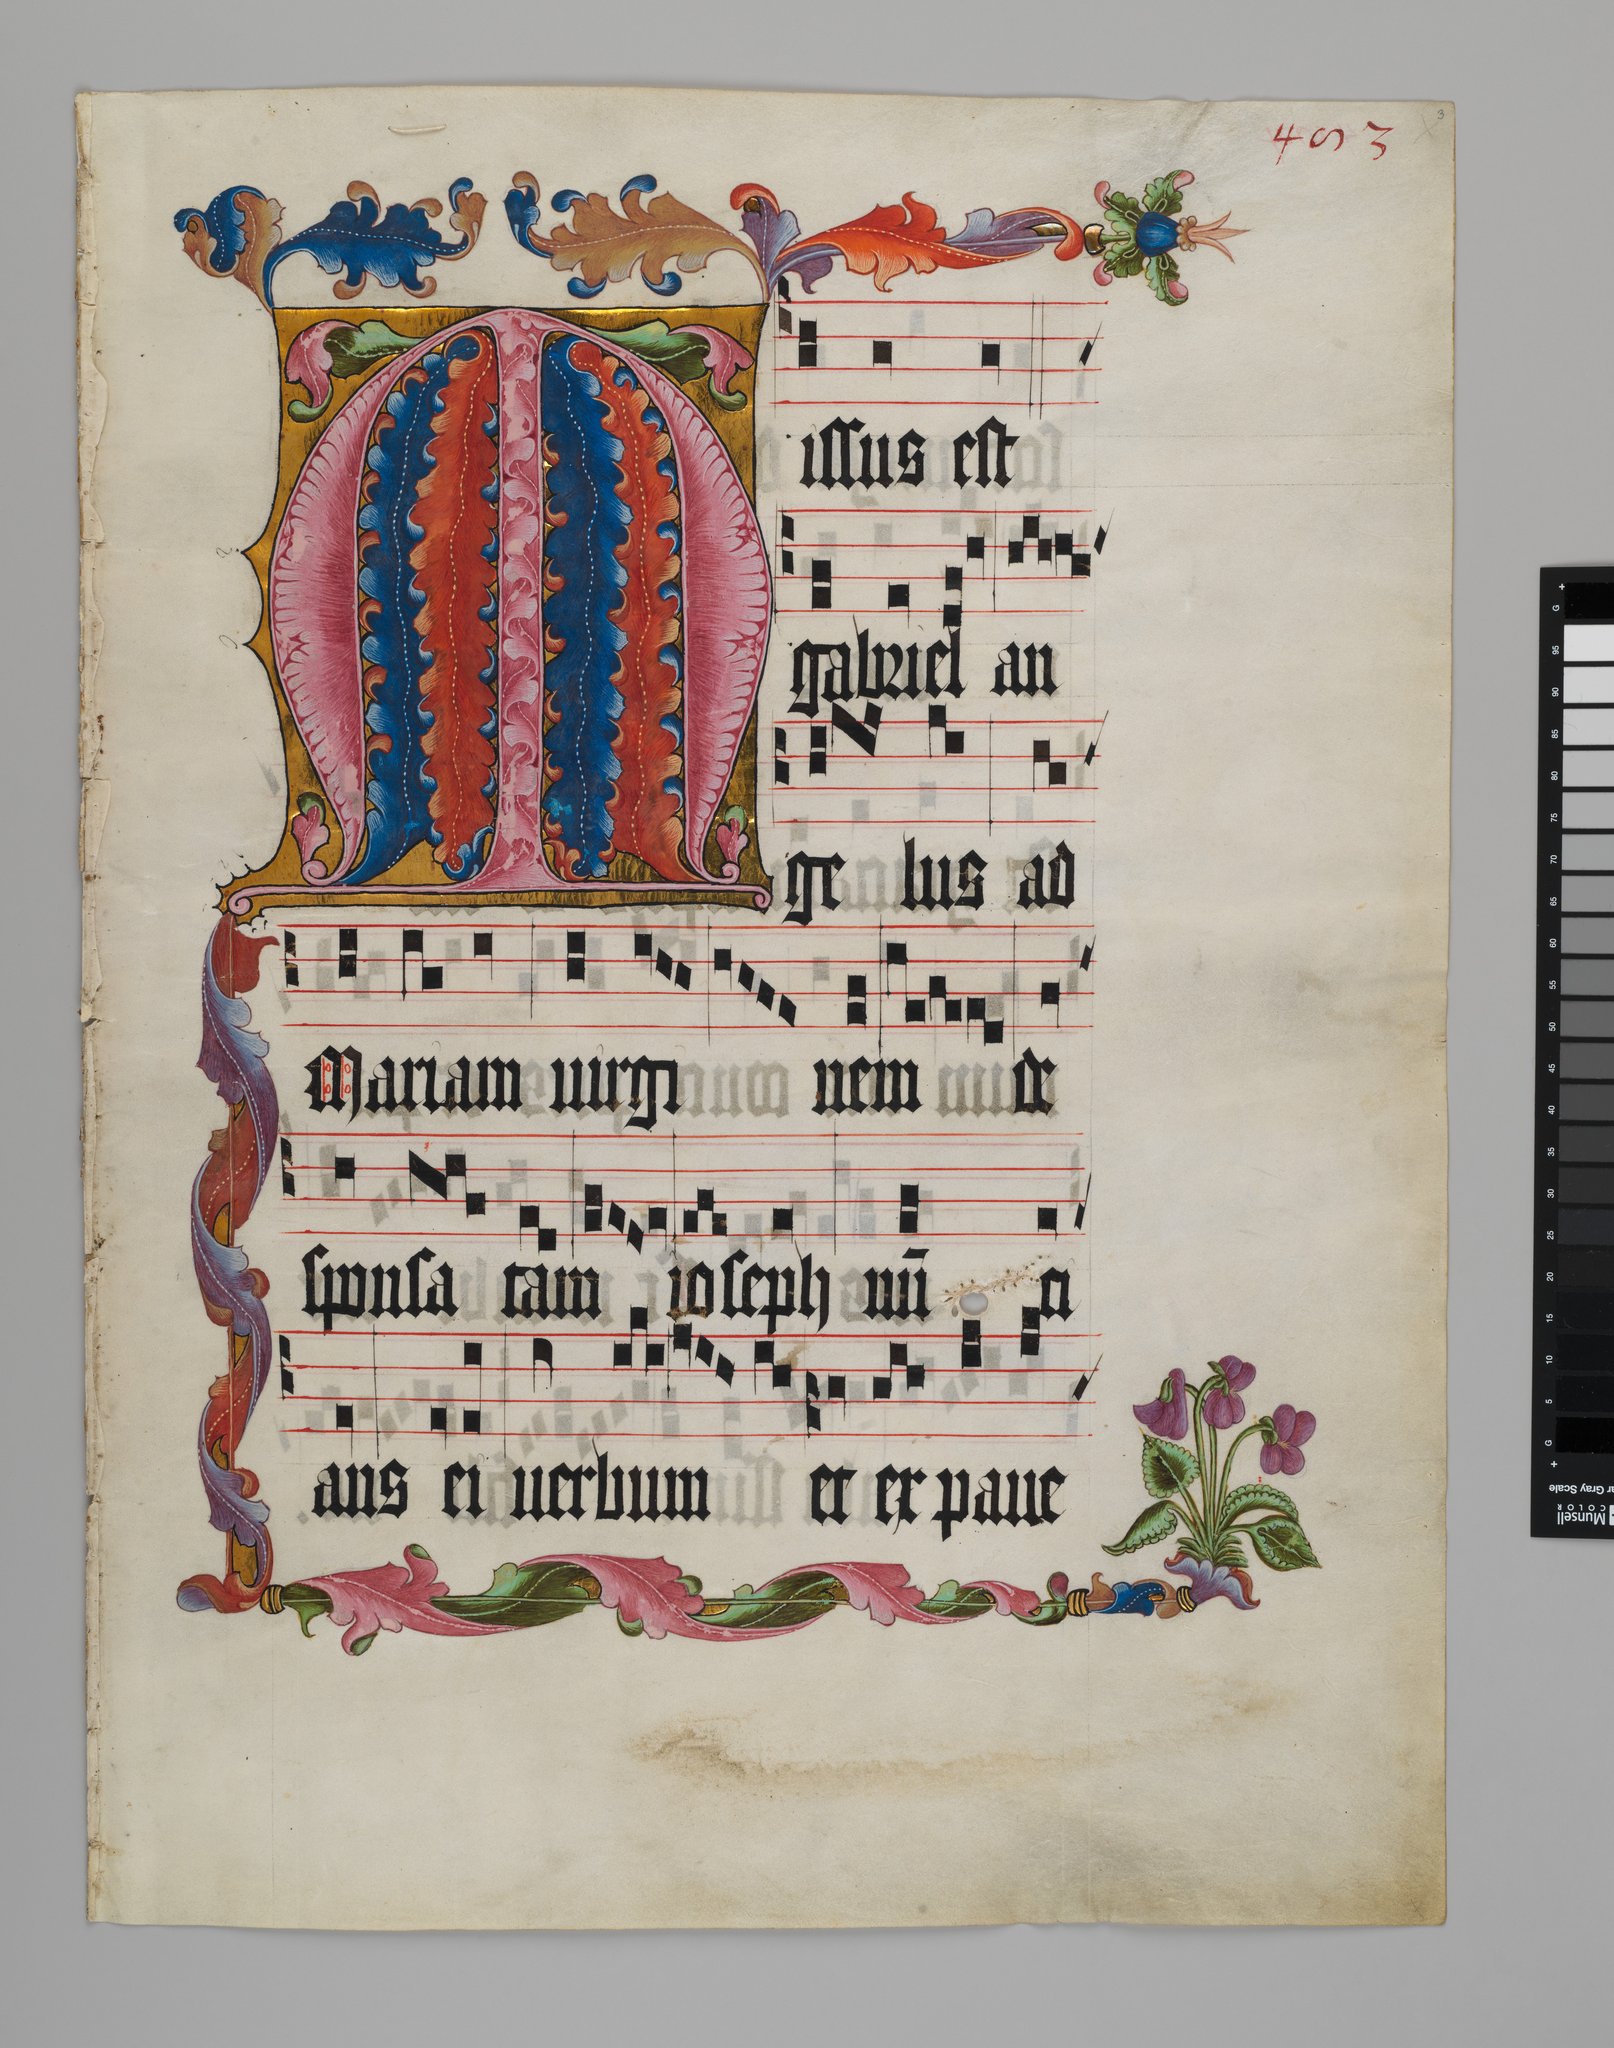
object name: antiphonary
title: Manuscript Leaf with the Initial M, from an Antiphonary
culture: german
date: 1425-1450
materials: ink, metal leaf, parchment, paint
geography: germany